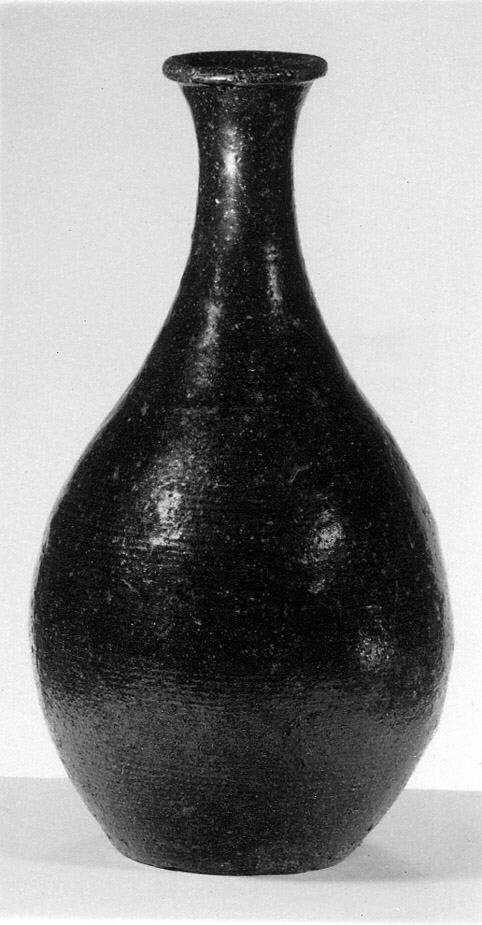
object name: bottle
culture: japanese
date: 1601-1633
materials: glaze, iron, stoneware